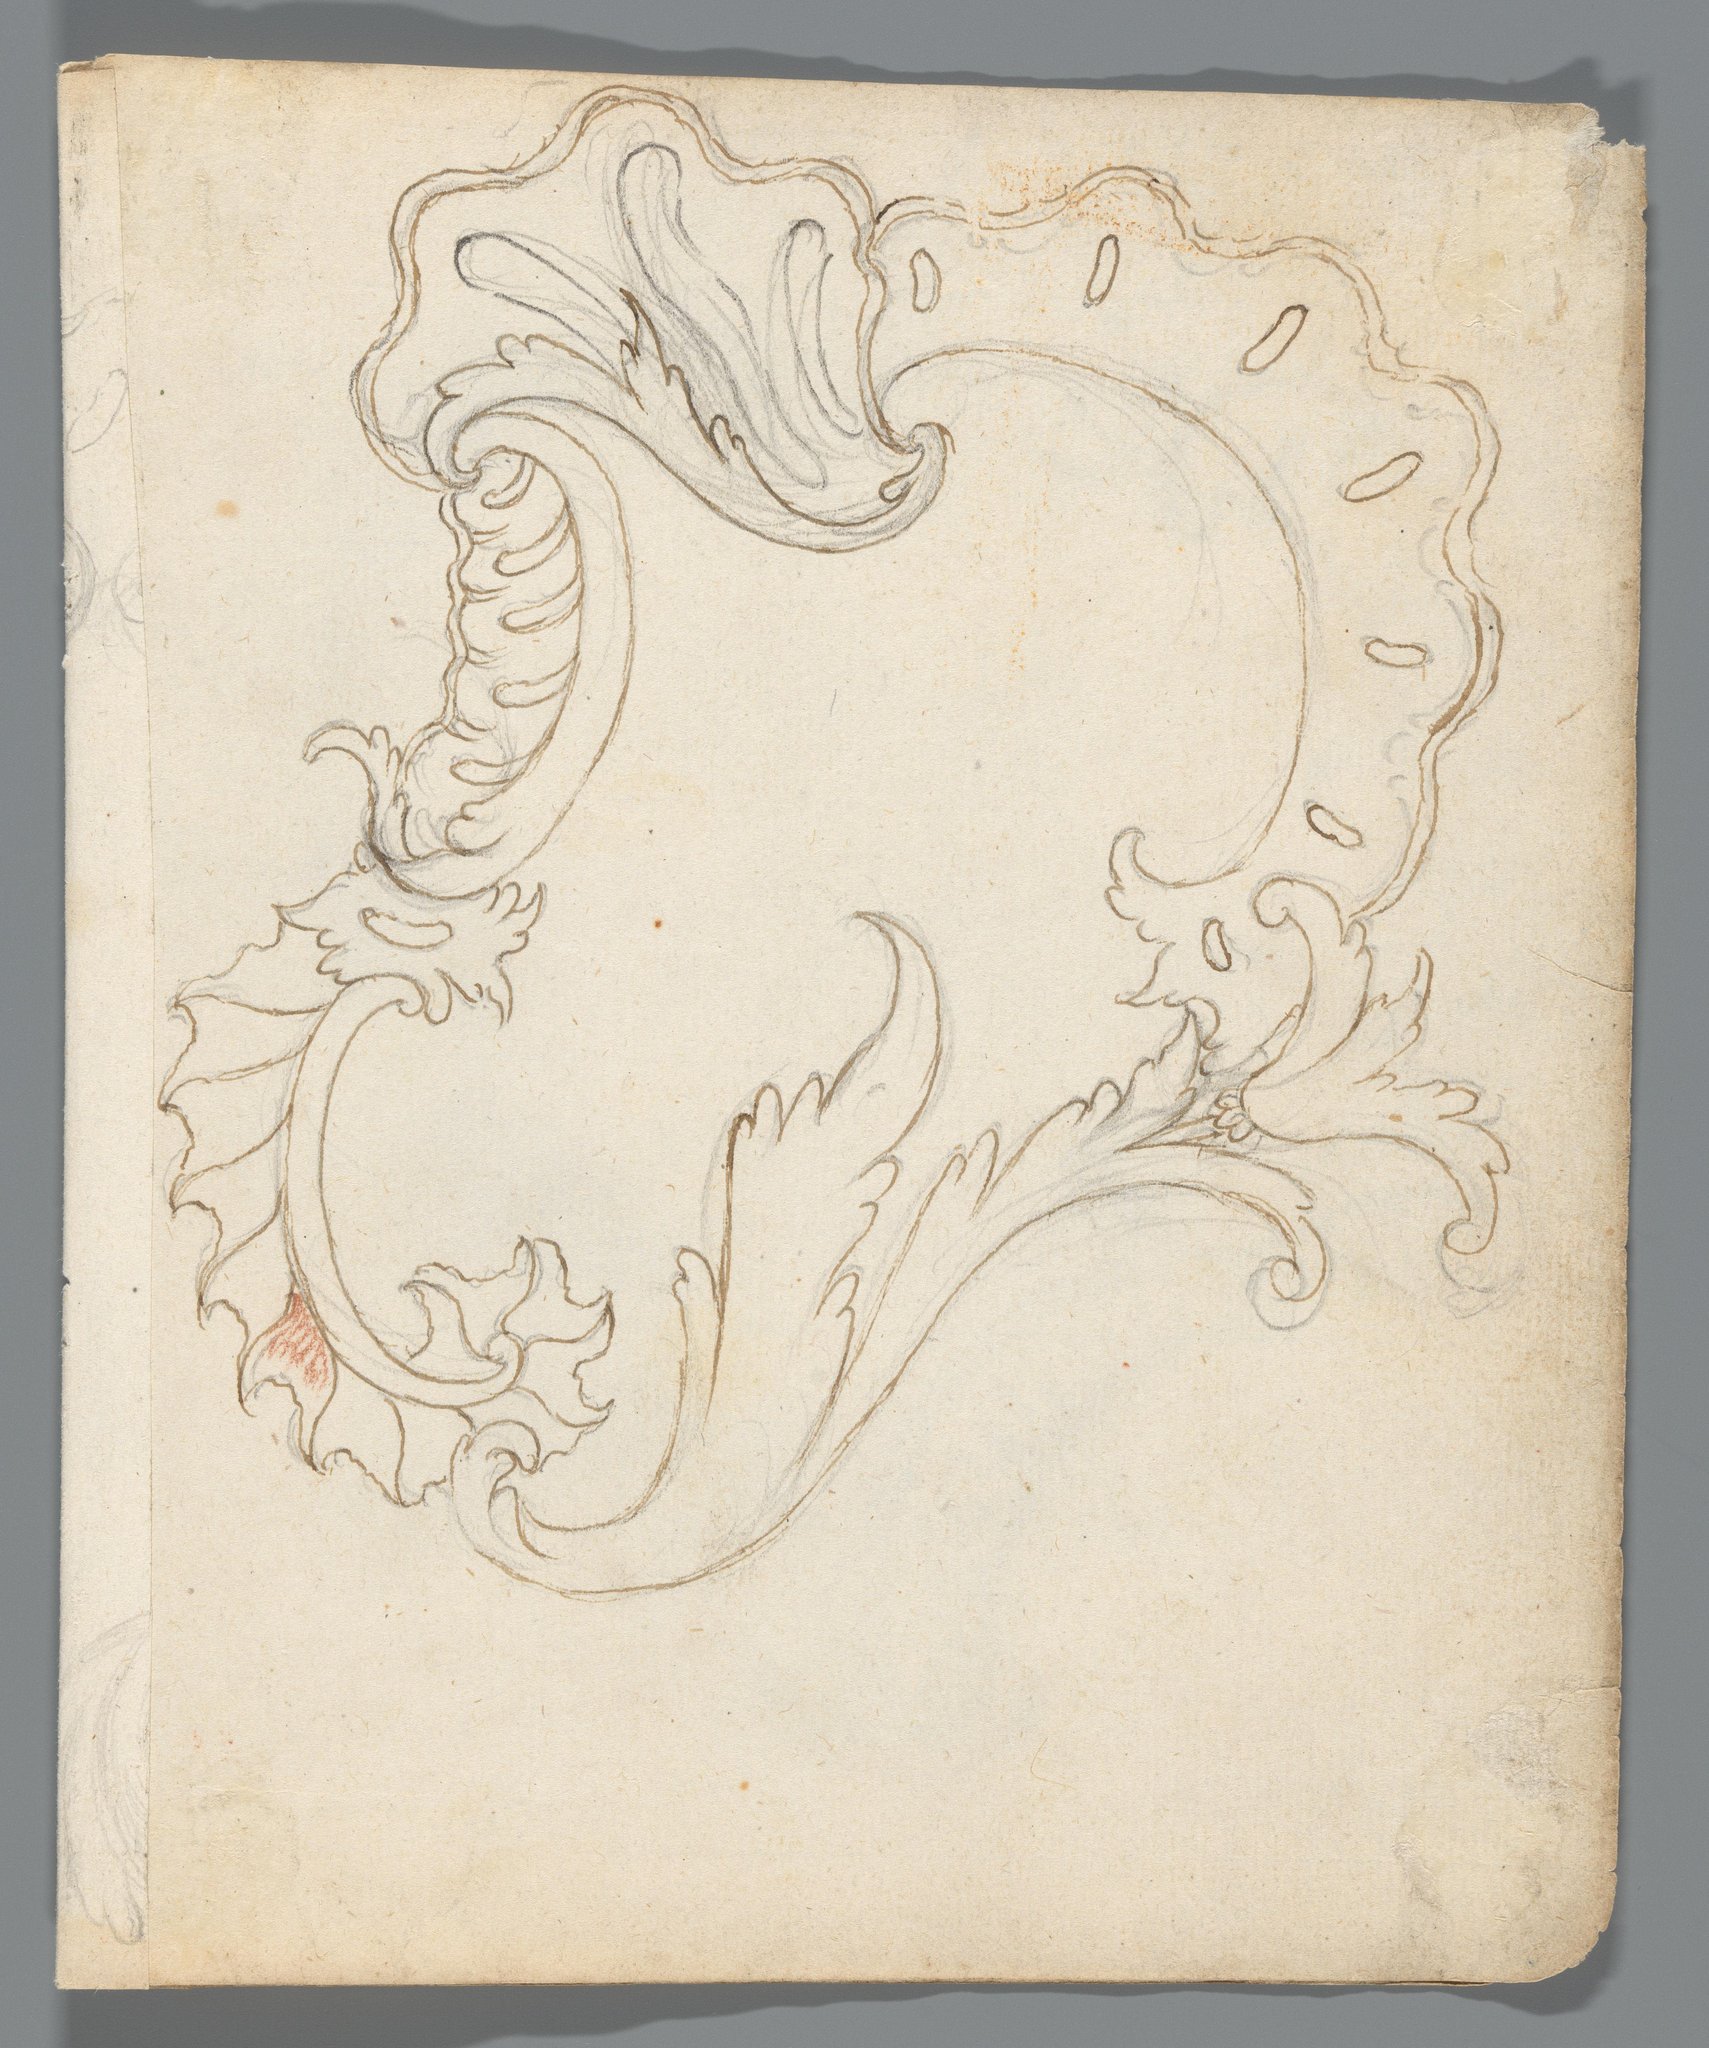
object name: drawing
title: Ontwerp voor een cartouche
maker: Anonymous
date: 1750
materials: chalk, ink, paper, pencil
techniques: pen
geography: netherlands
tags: scallop, shell ~ ornament - aa - stylized, ornament ~ cartouche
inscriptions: watermark, watermark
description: Ontwerp voor een cartouche in rococostijl. Onderdeel van het album (gedeeltelijk losbladig) met zestien ontwerpen voor cartouches.